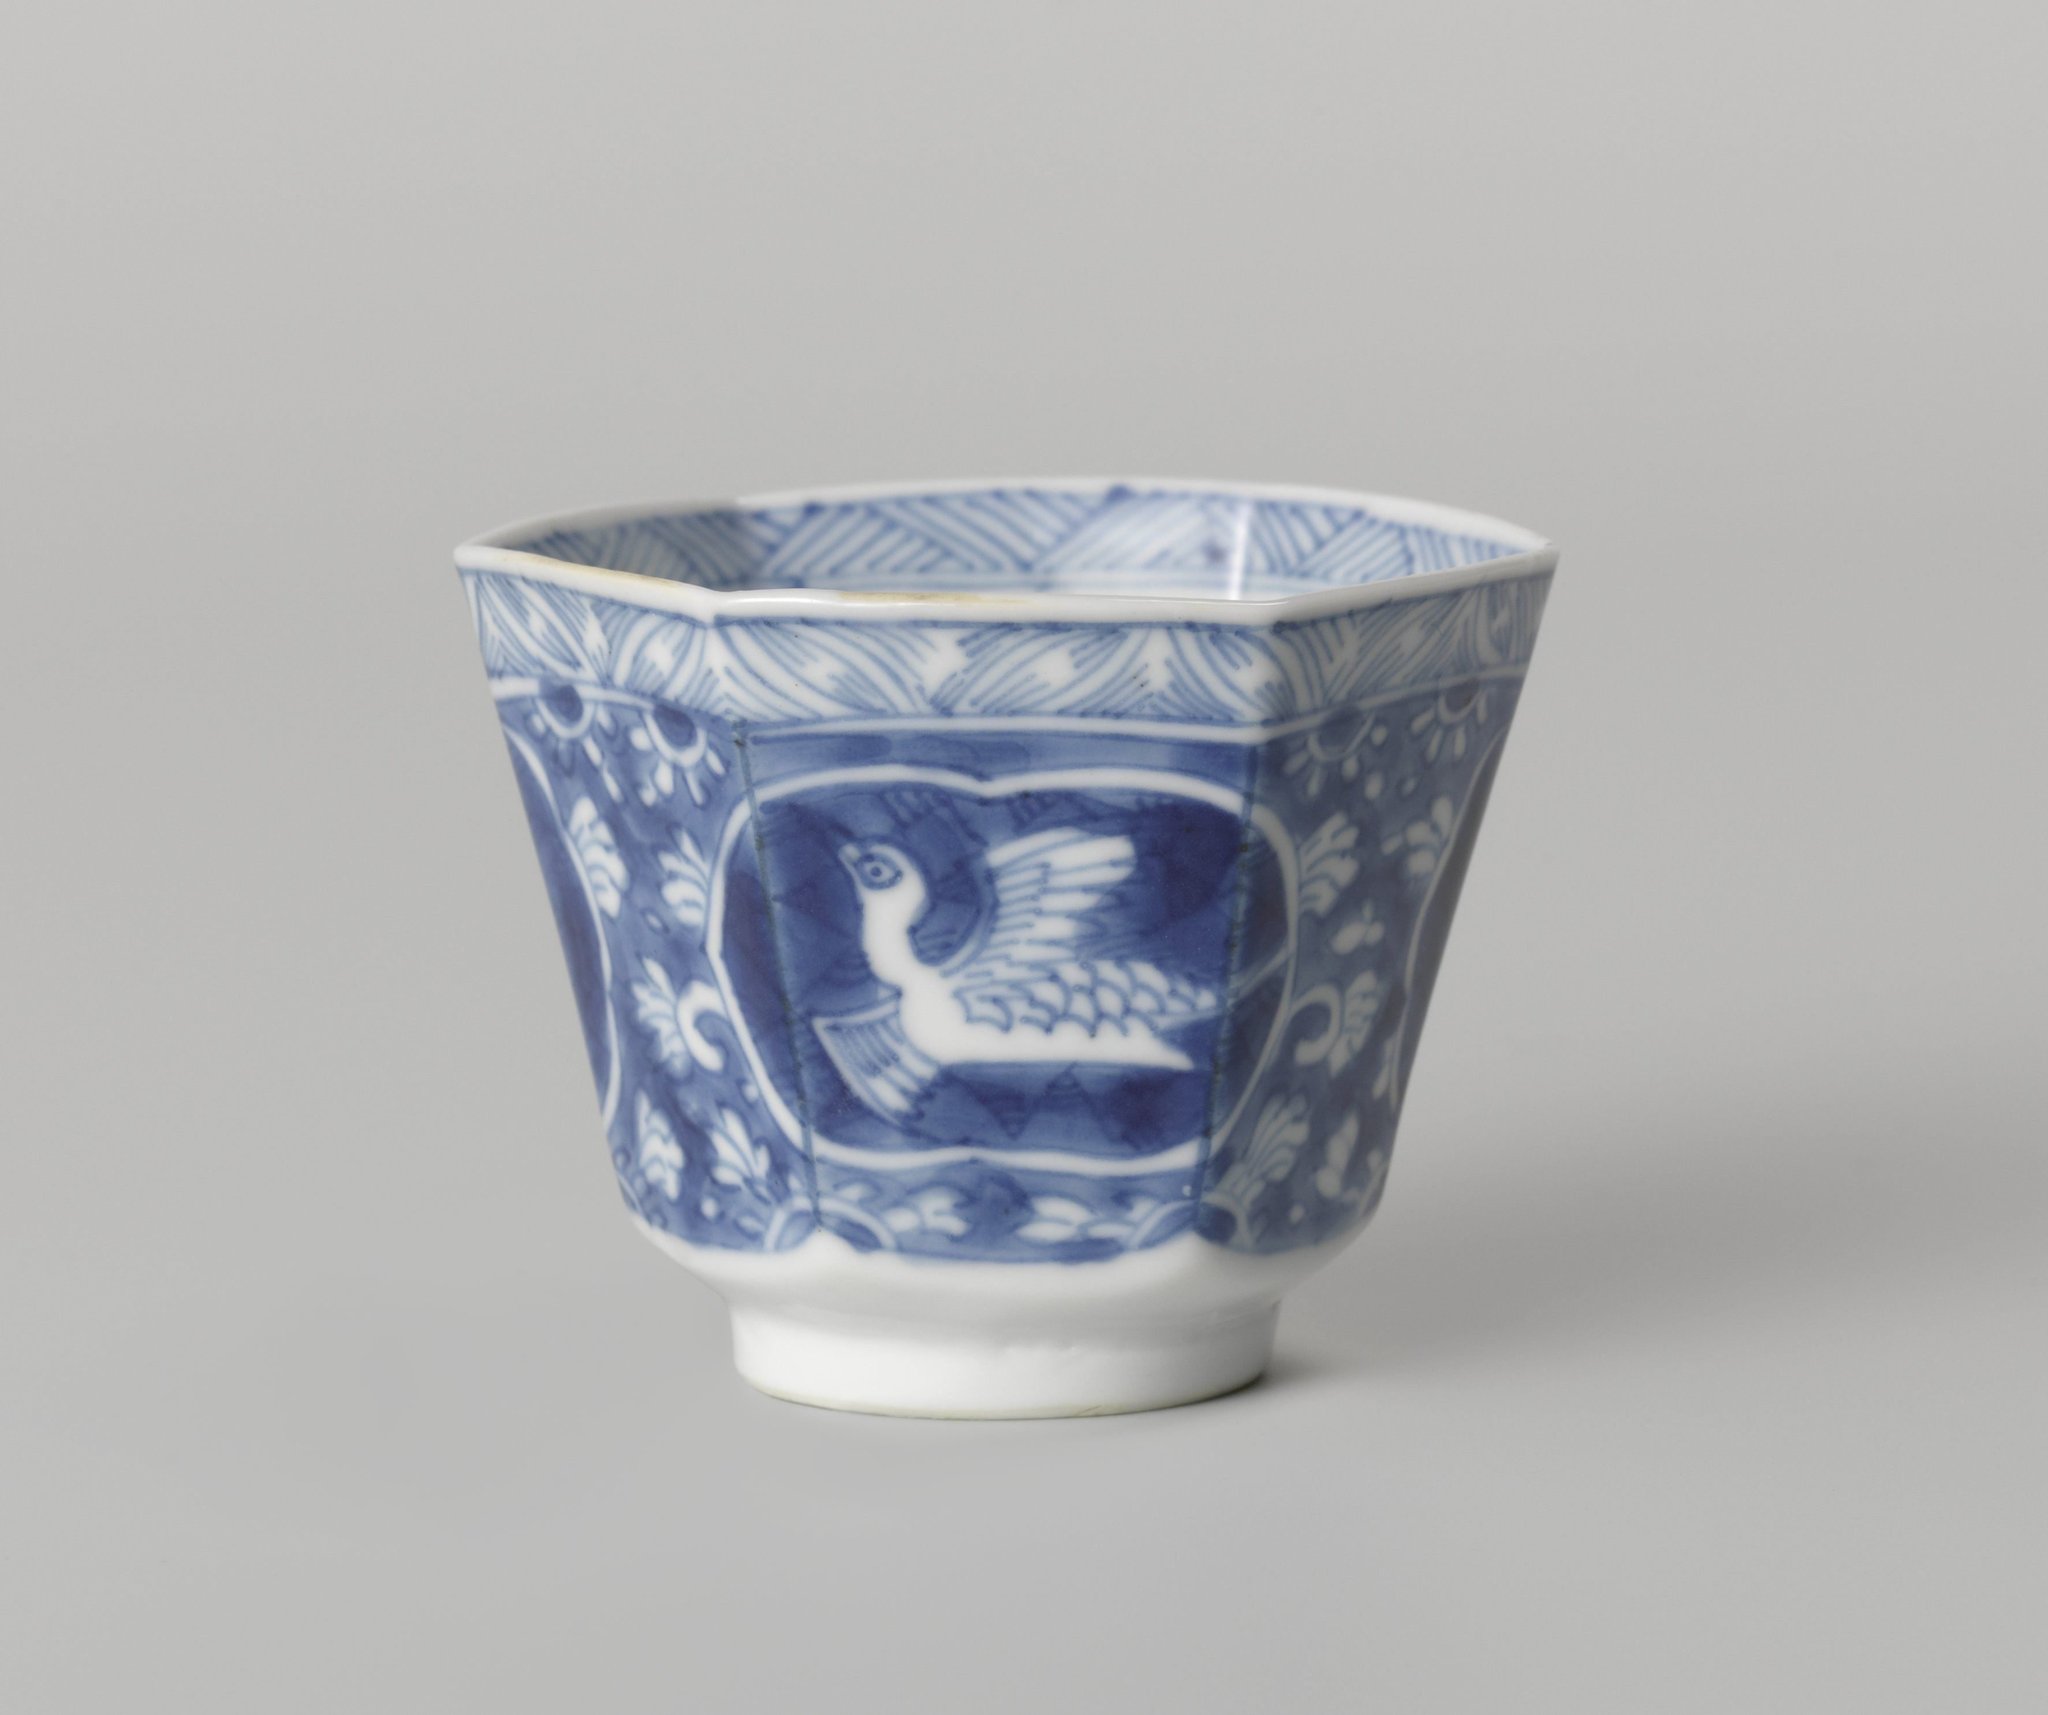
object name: cup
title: Hexagonal cup with a flying crane in a panel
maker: Anonymous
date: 1700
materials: cobalt, glaze, paint, porcelain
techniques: firing, turning, vitrification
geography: china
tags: shore-birds and wading-birds: crane, ornament derived from plant forms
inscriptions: mark: ‘福’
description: Kop van porselein, zeshoekige, beschilderd in onderglazuurblauw met twee velden in de vorm van een lotusbloem gevuld met een kraanvogel en twee kleinere bladmotieven. Gemerkt op de bodem met een vierkant 'Fu'-merk in een dubbele cirkel.